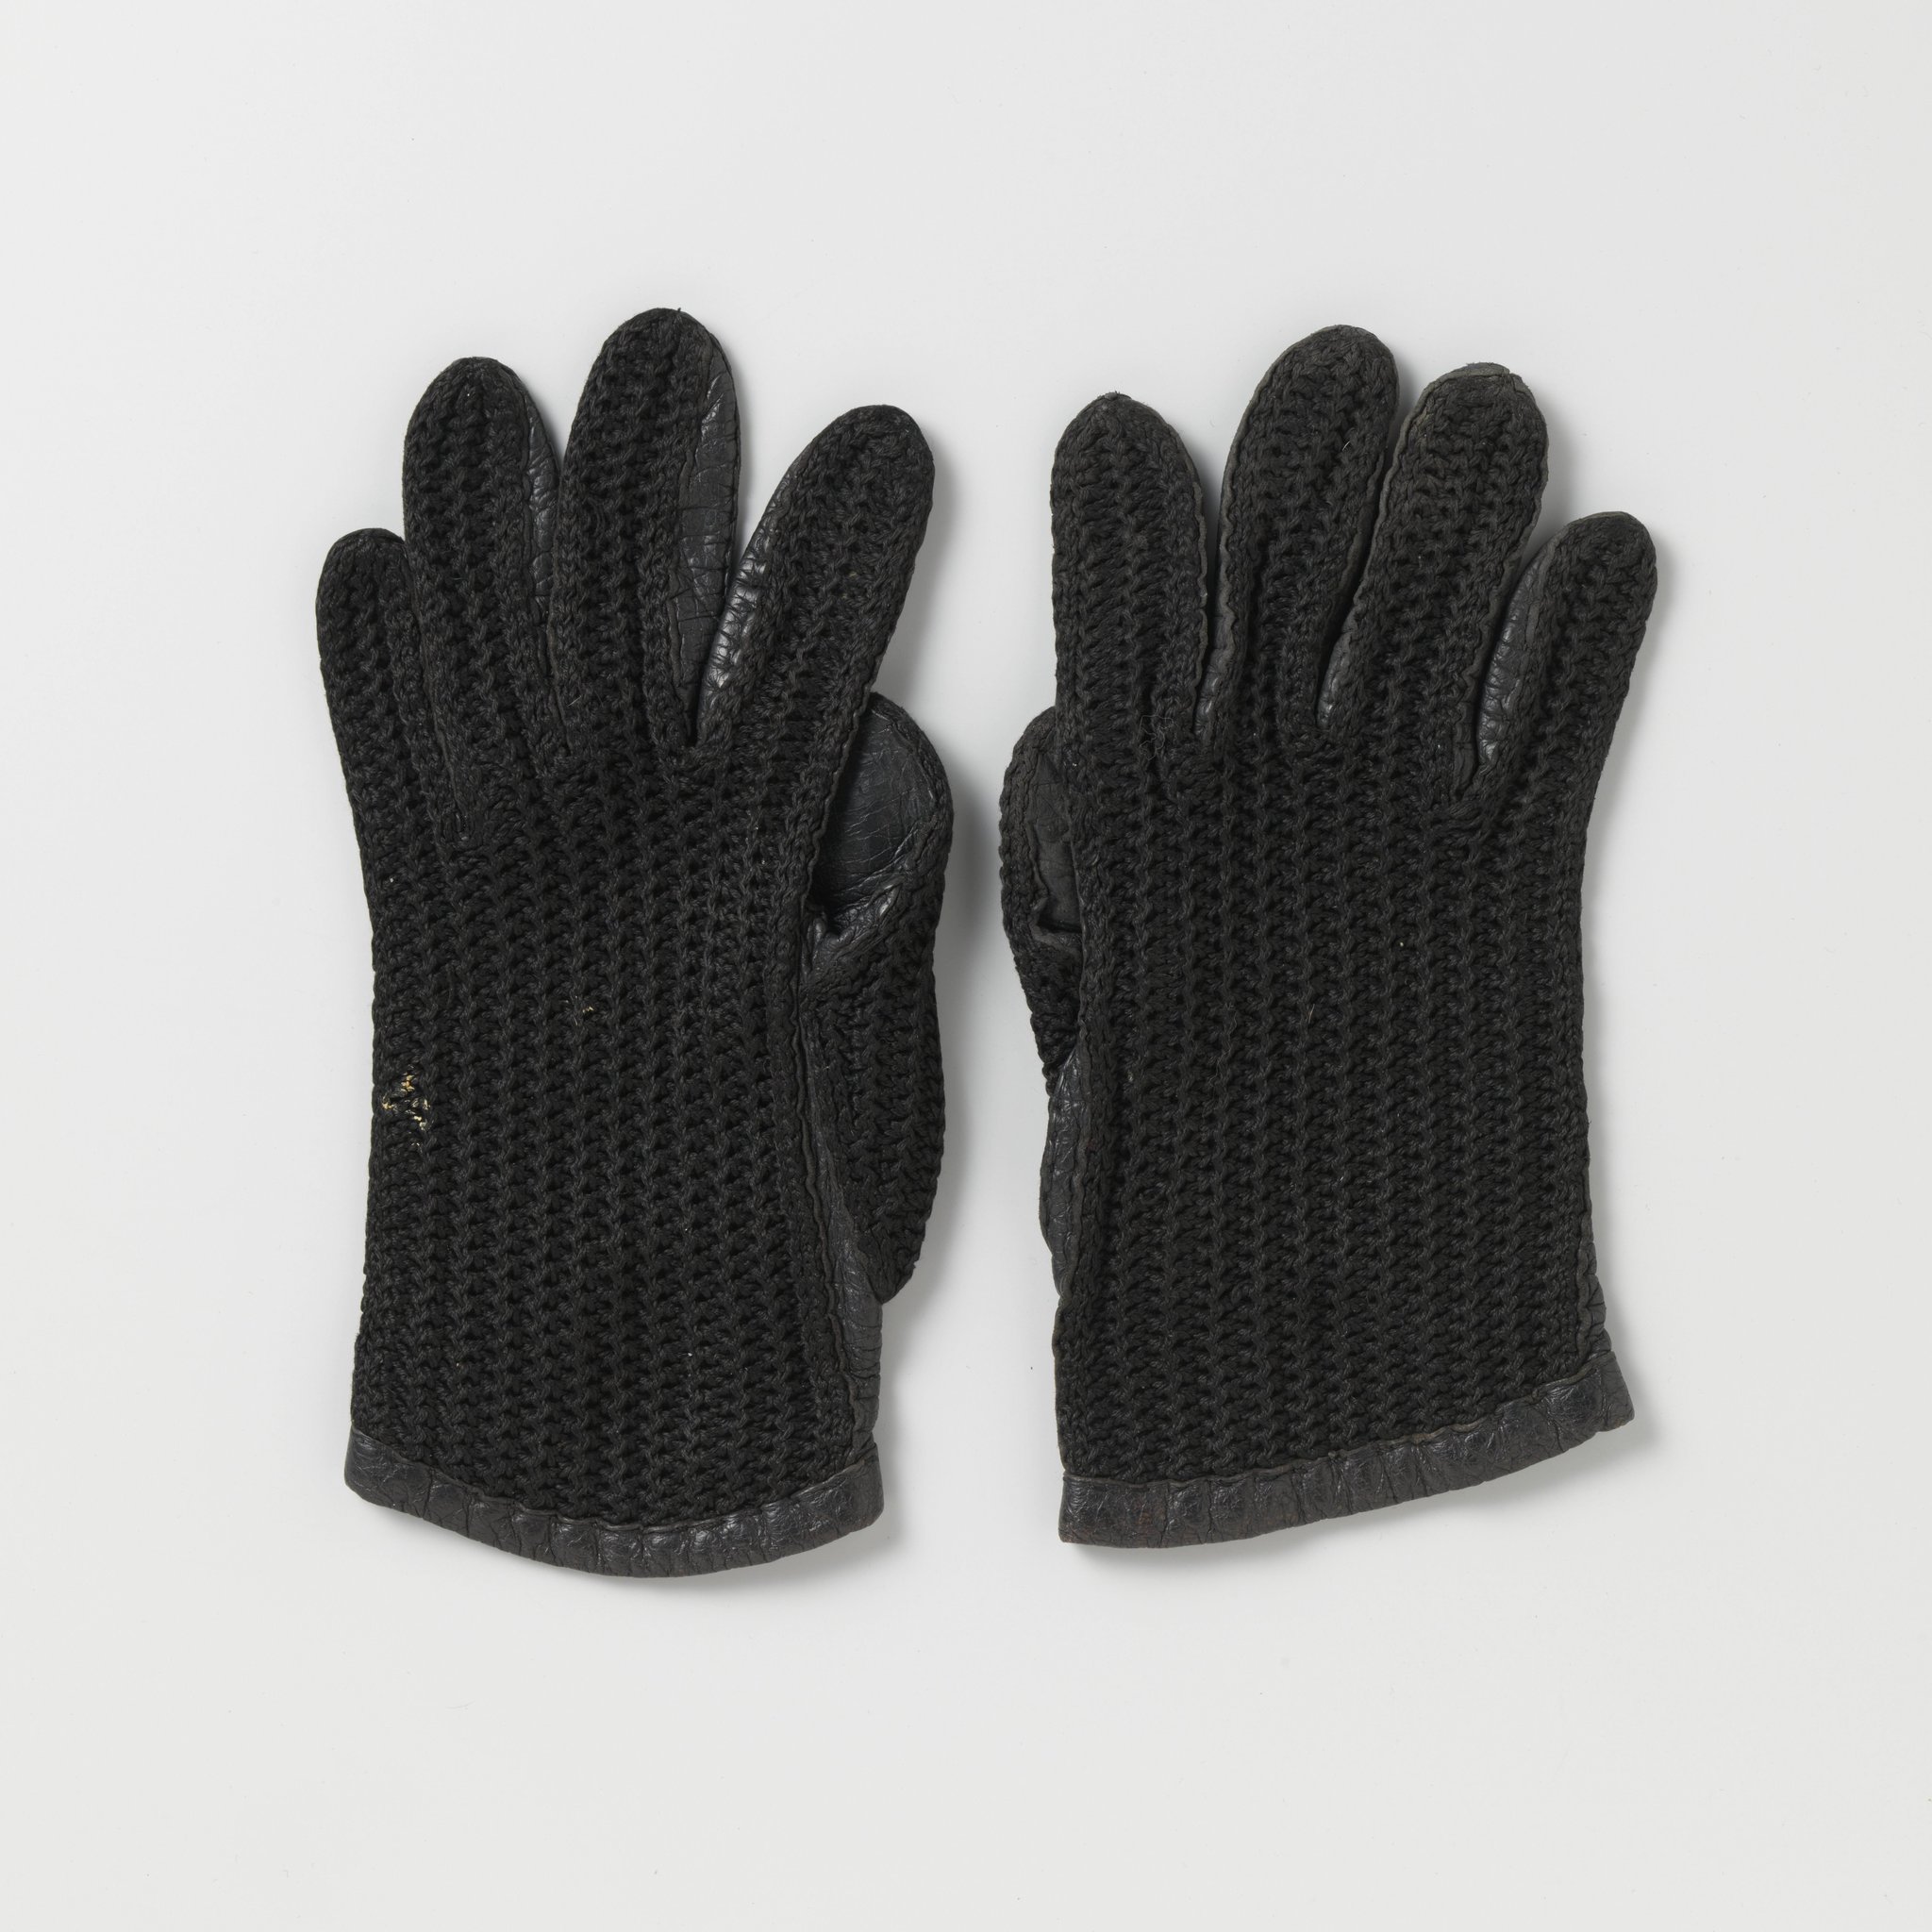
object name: glove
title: Rechterhandschoen van zwart leer en gebreide katoen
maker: Anonymous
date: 1950-1975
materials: cotton, leather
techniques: knitting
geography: netherlands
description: Rechterhandschoen van zwart leer en gebreide katoen, met split bij de pols.